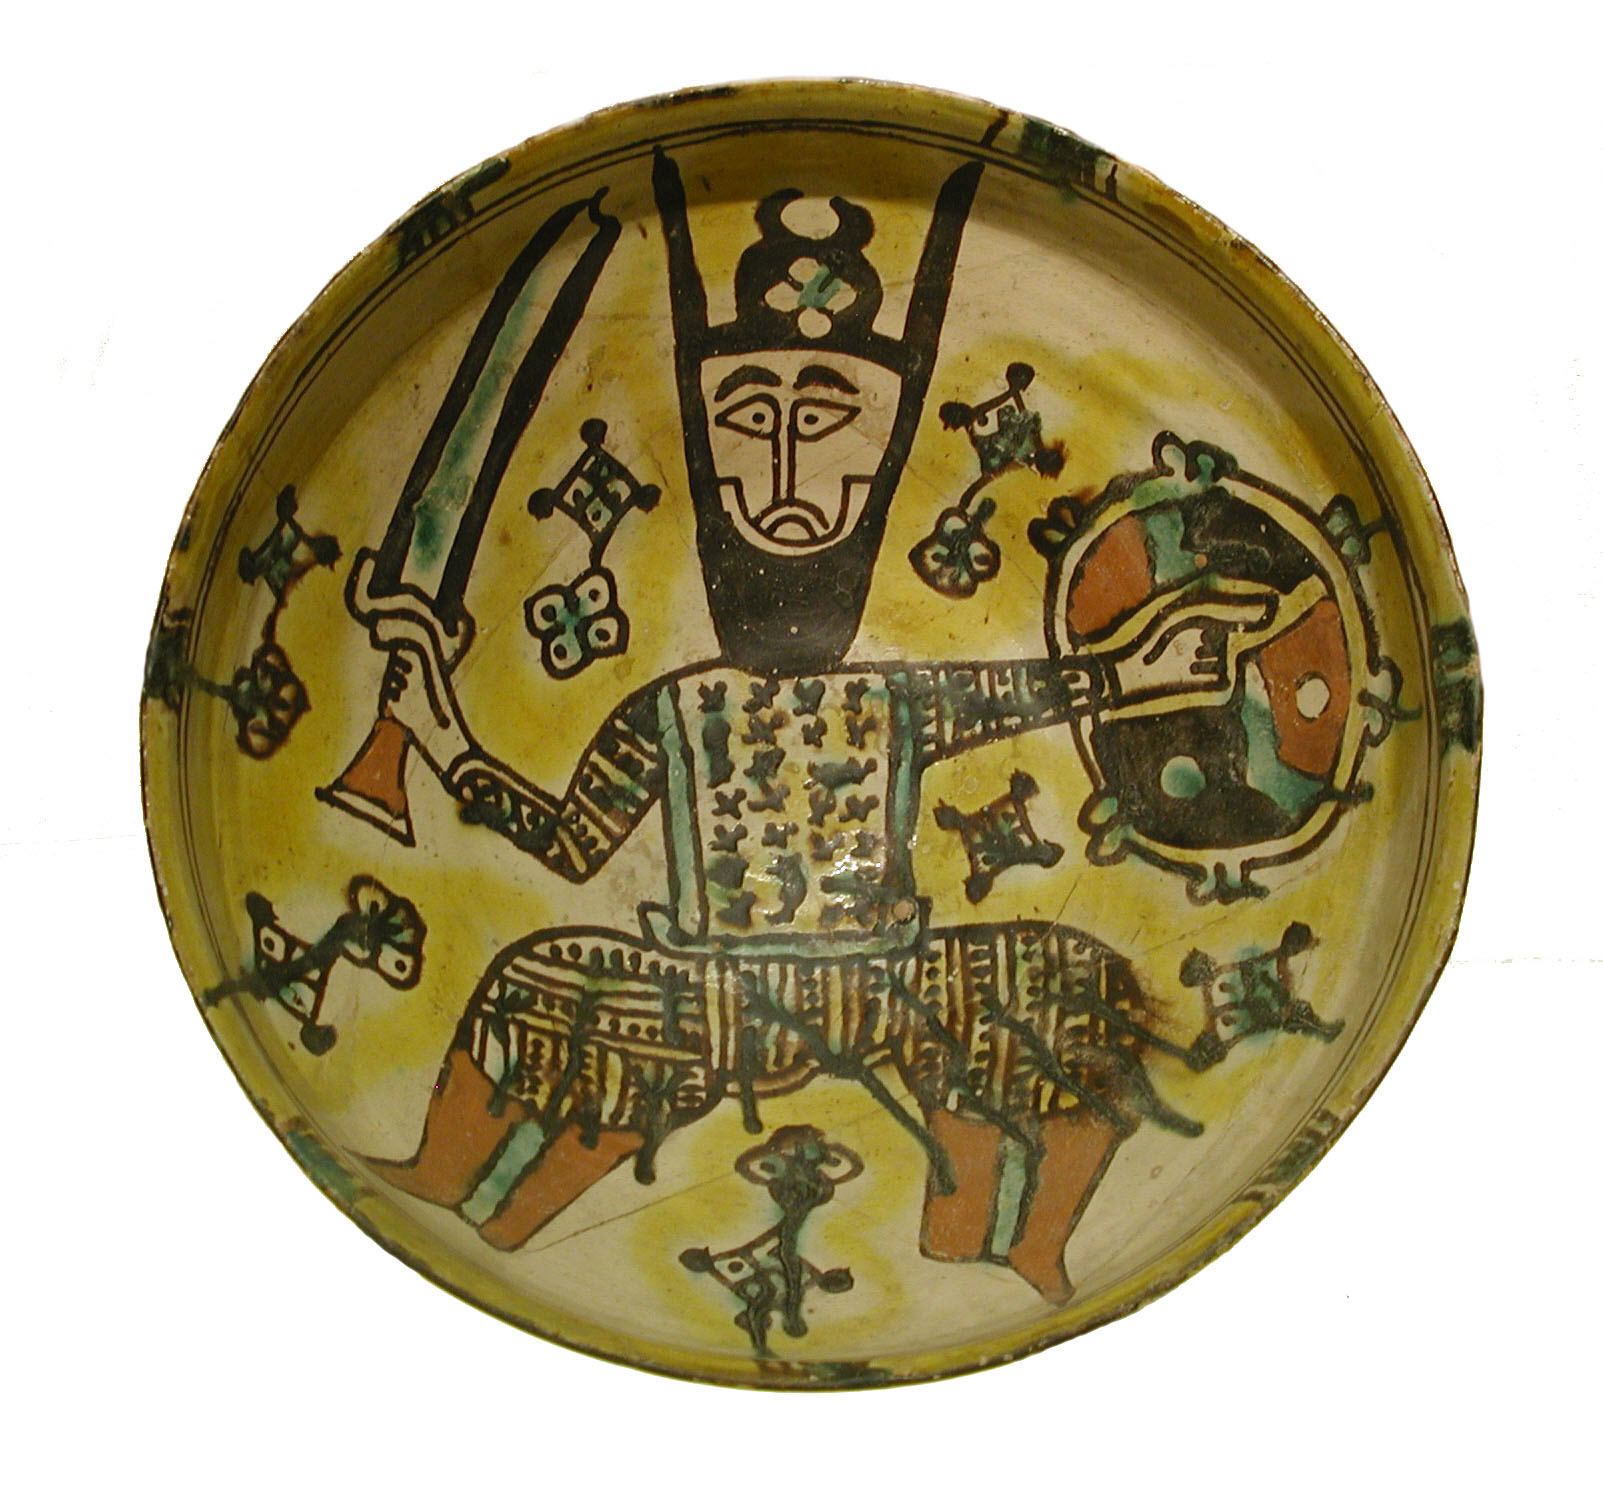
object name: bowl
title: Bowl with a Man Holding a Sword and Shield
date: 901-1000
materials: earthenware, glaze, pigment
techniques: polychrome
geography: iran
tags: shields,swords,men